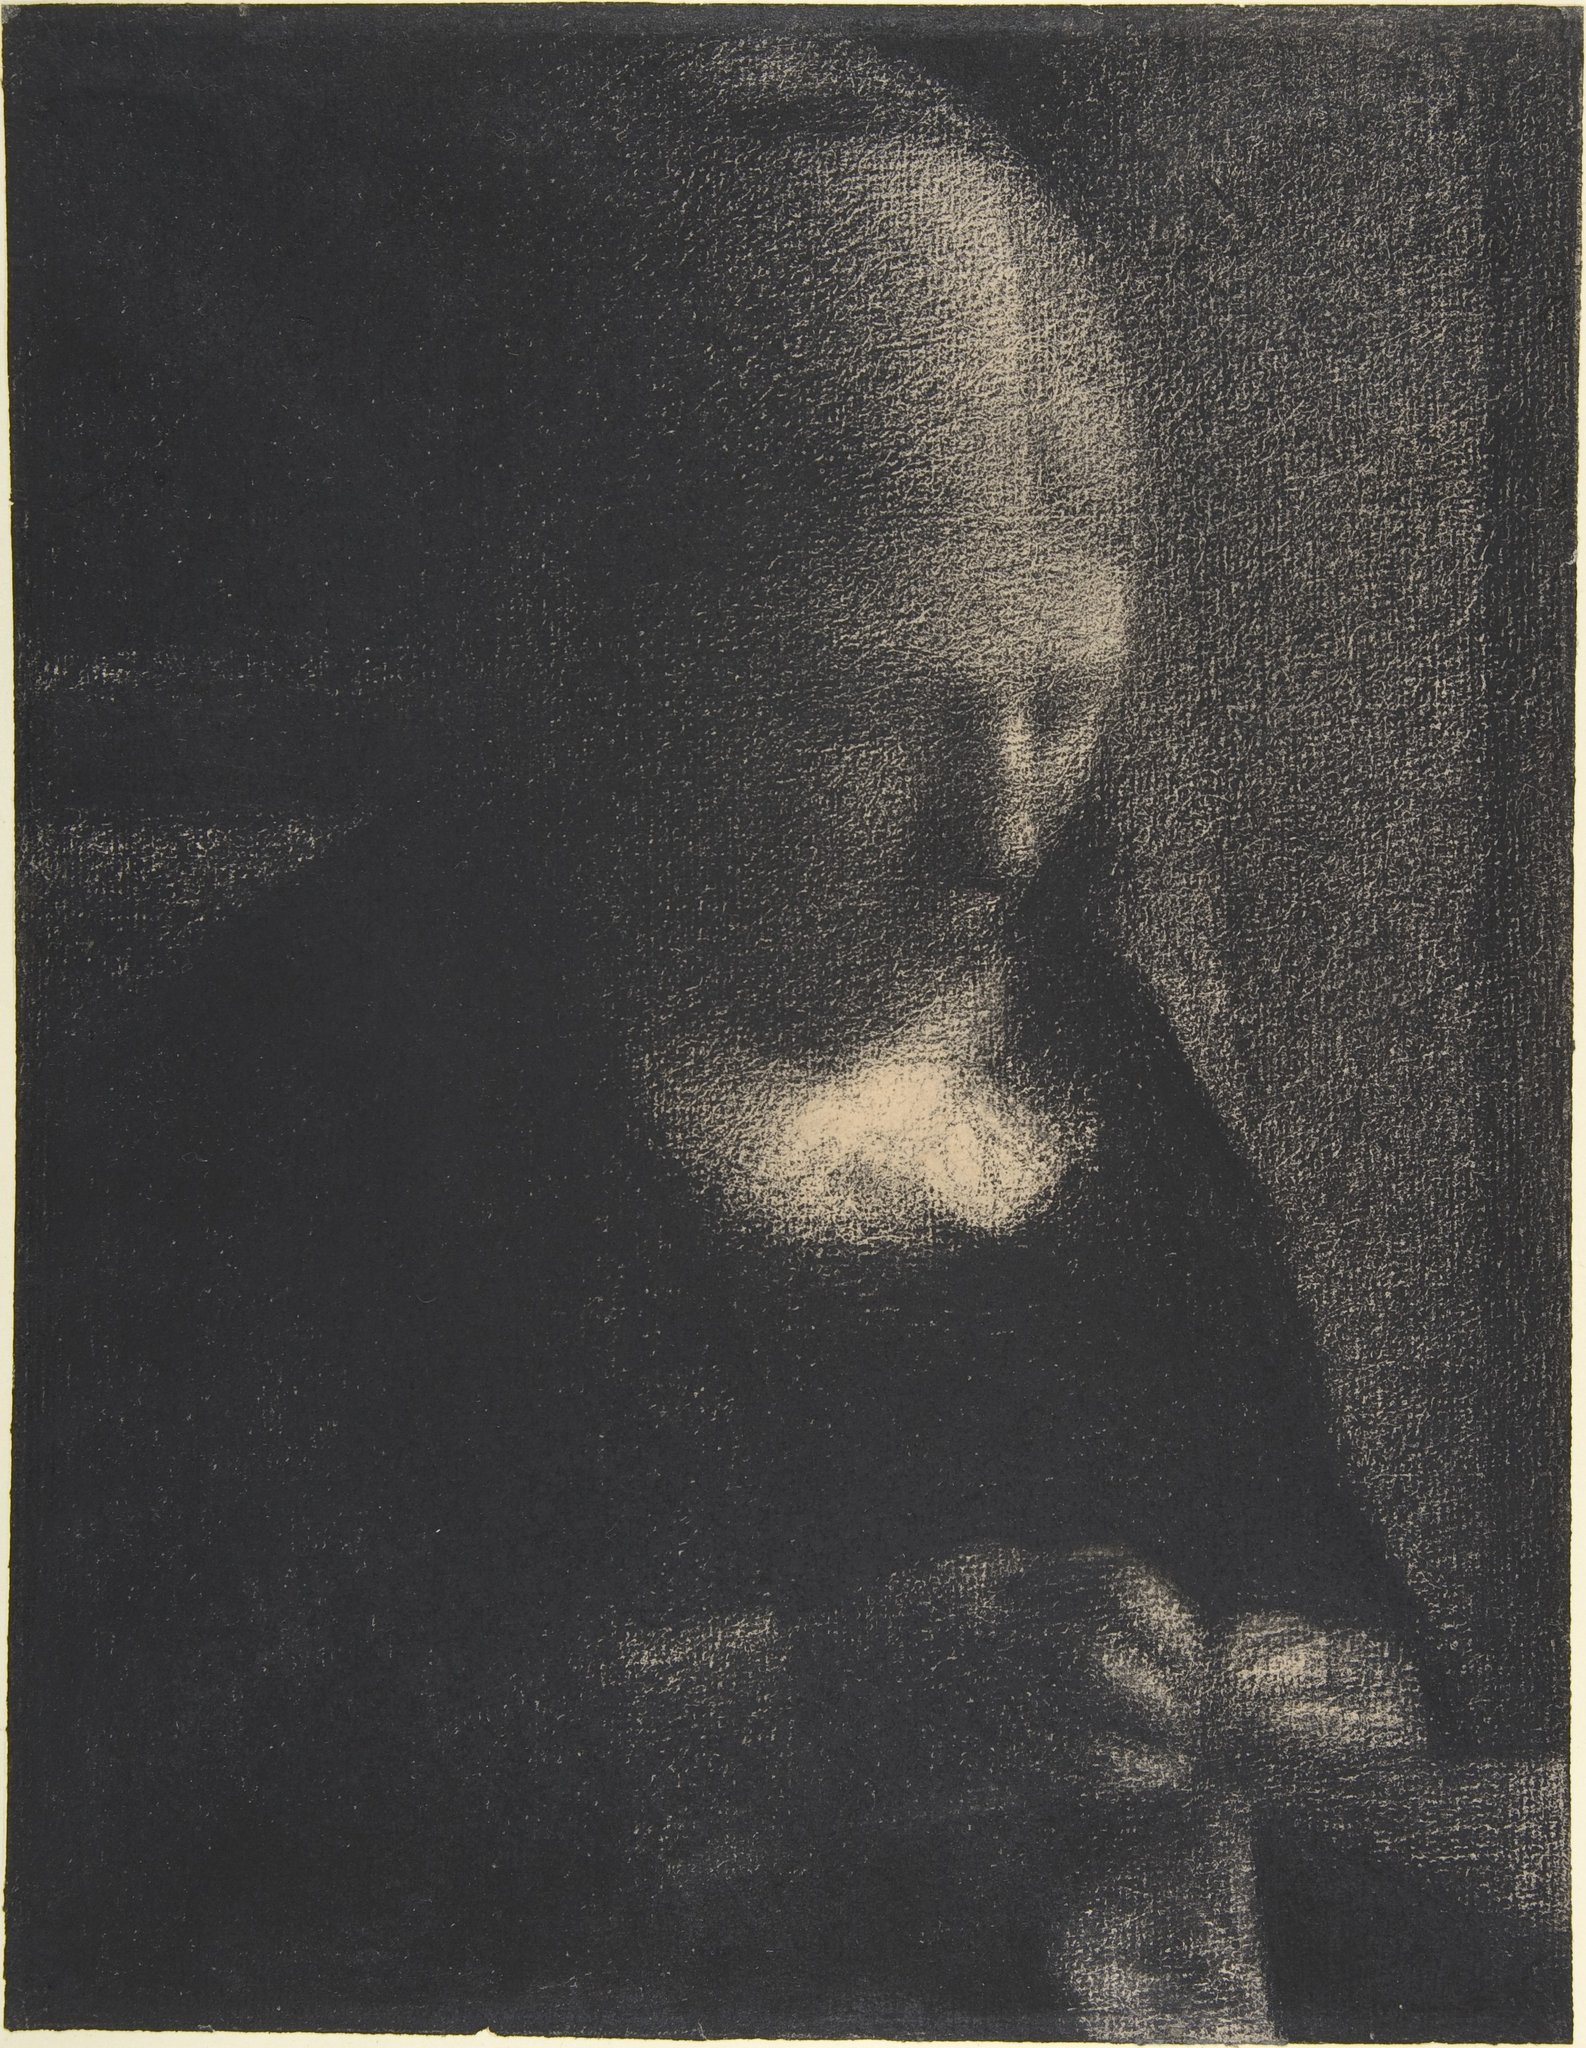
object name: drawing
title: Embroidery; The Artist's Mother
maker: georges seurat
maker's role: artist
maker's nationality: french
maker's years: 1859-1891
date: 1882-1883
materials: crayon, paper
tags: portraits,women